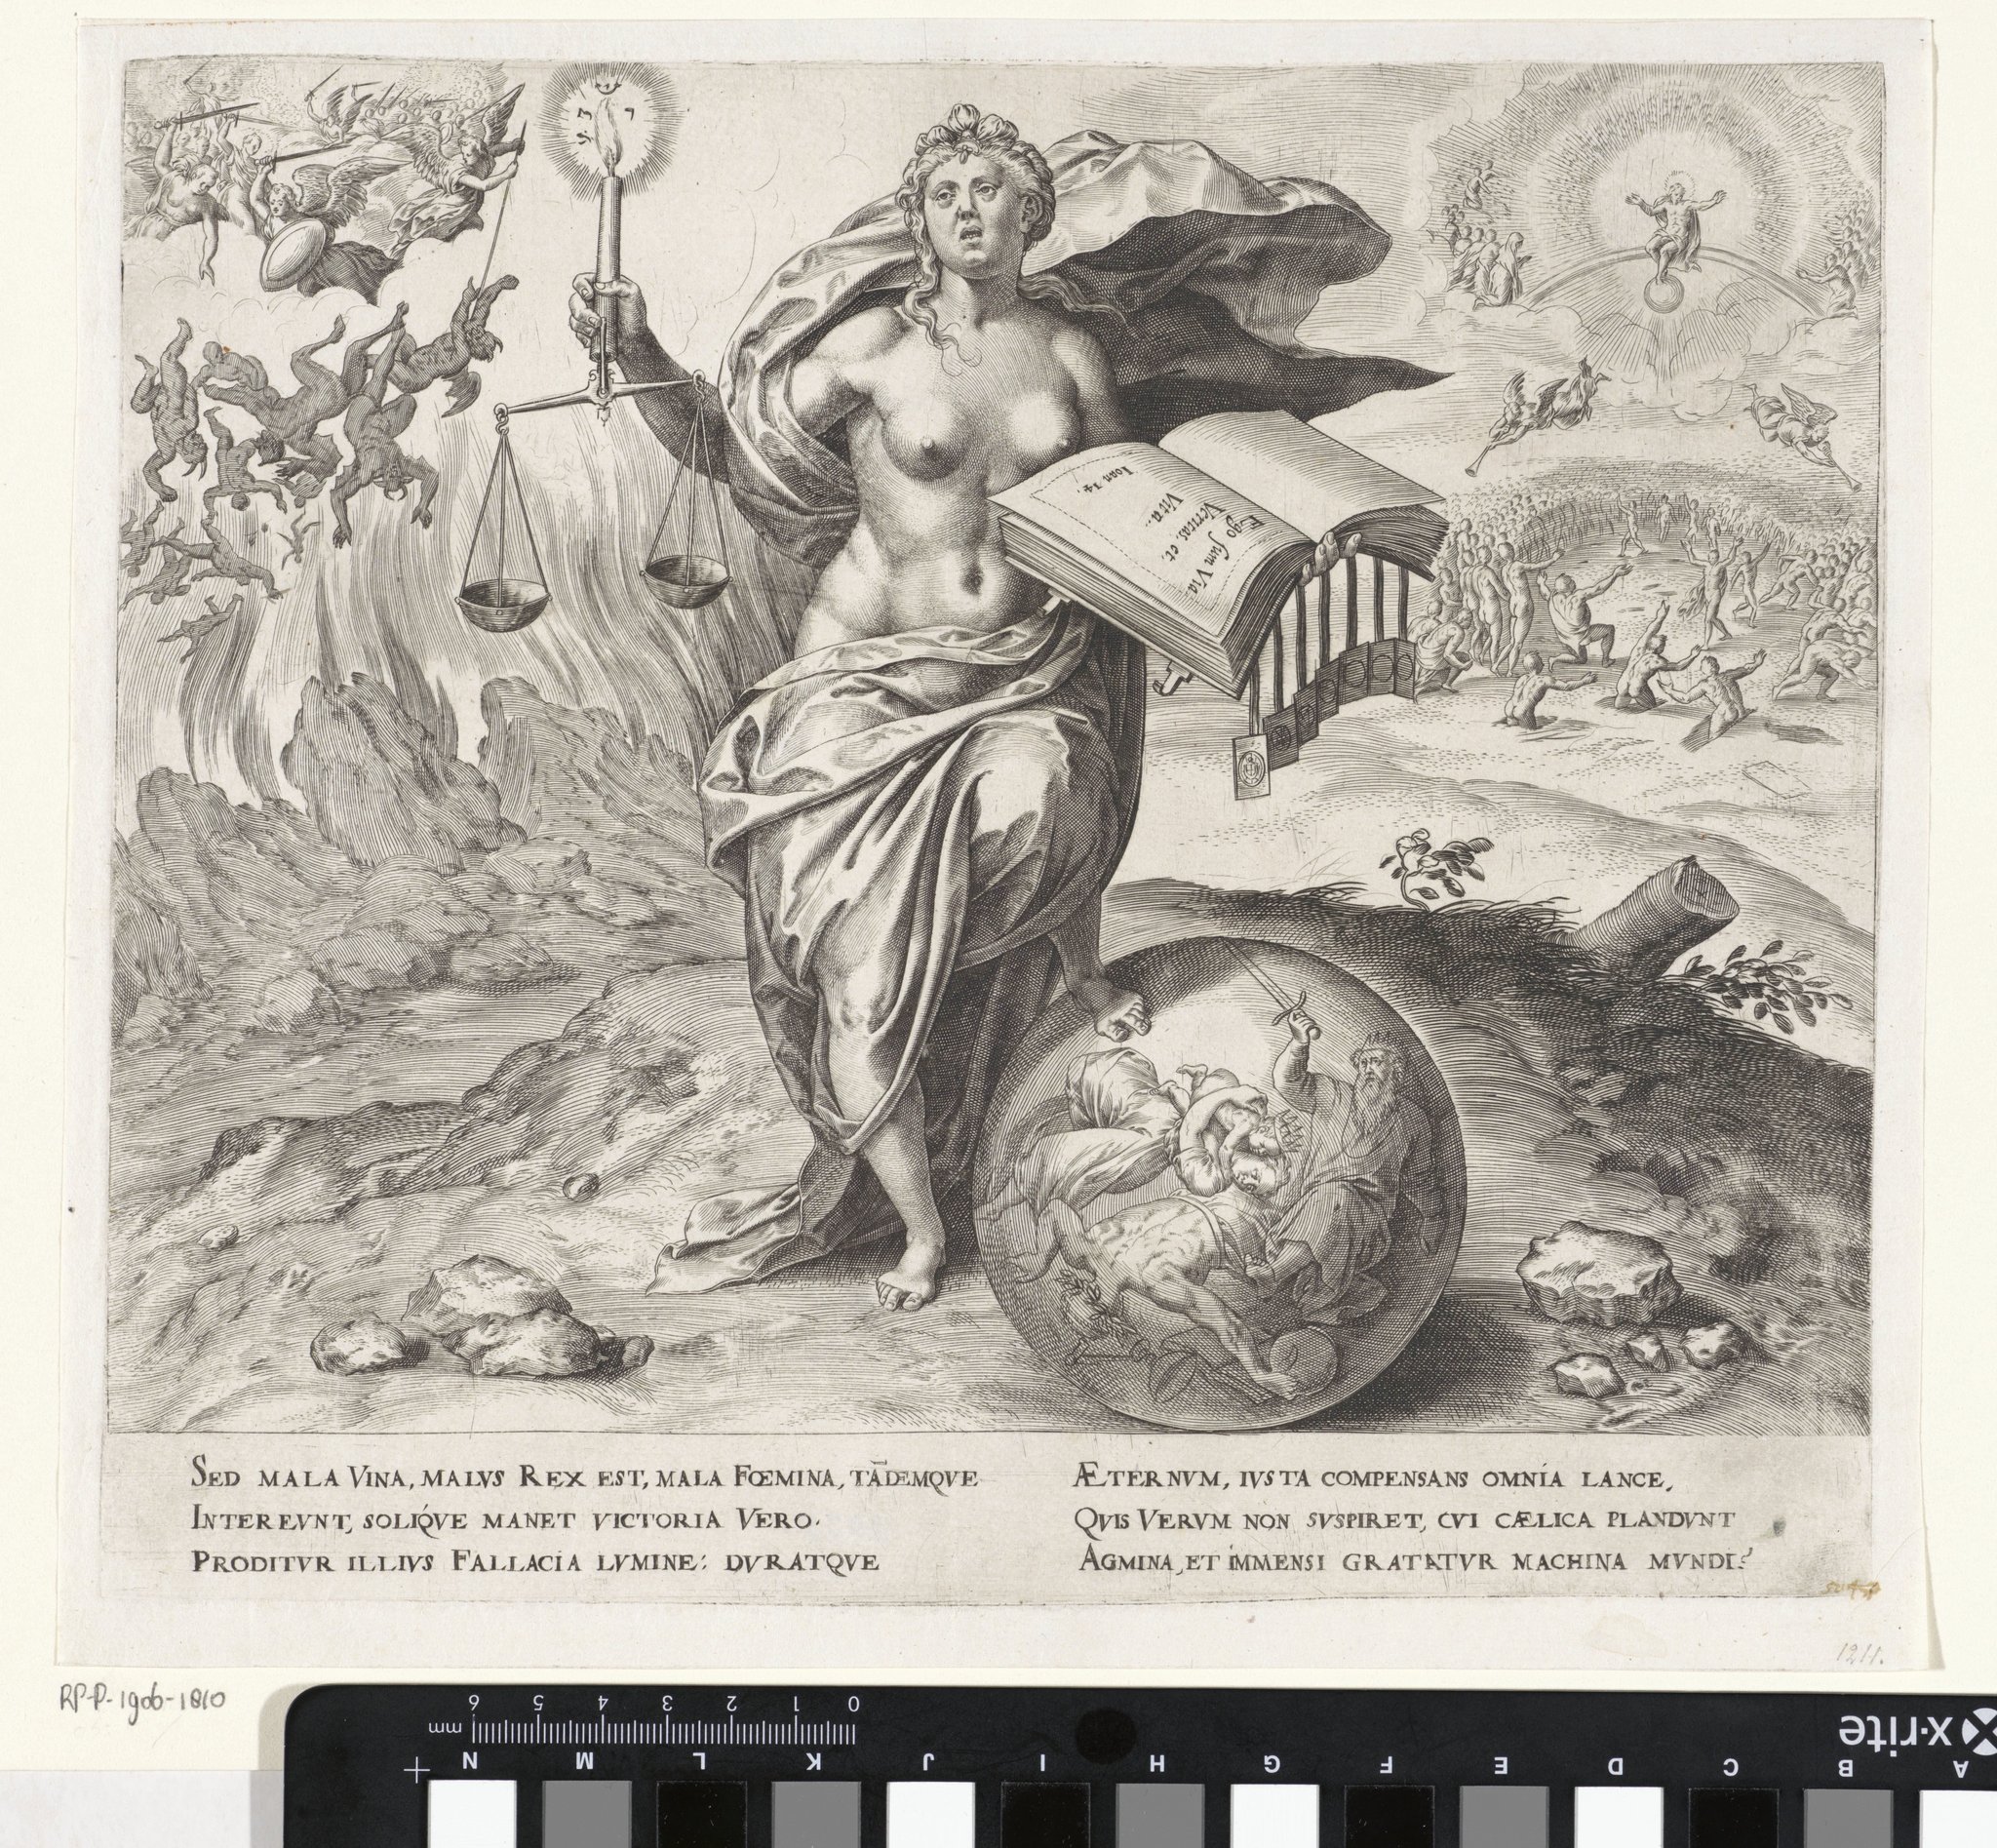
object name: print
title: Macht van de waarheid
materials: paper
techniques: engraving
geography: antwerp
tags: fall of the rebel angels, who become devils, last judgement, truth; 'verità' (ripa)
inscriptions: number: ‘50’, collector's mark: Lugt 2228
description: De vrouwelijke personificatie van Waarheid staat met haar voet op een globe waar de andere machten in zijn opgesloten. In haar handen houdt ze een weegschaal, een brandende kaars en een opengeslagen boek met zeven zegels. Links op de achtergrond de val van de opstandige engelen. Rechts op de achtergrond het Laatste Oordeel. In de marge een zesregelig onderschrift, in twee kolommen, in het Latijn.